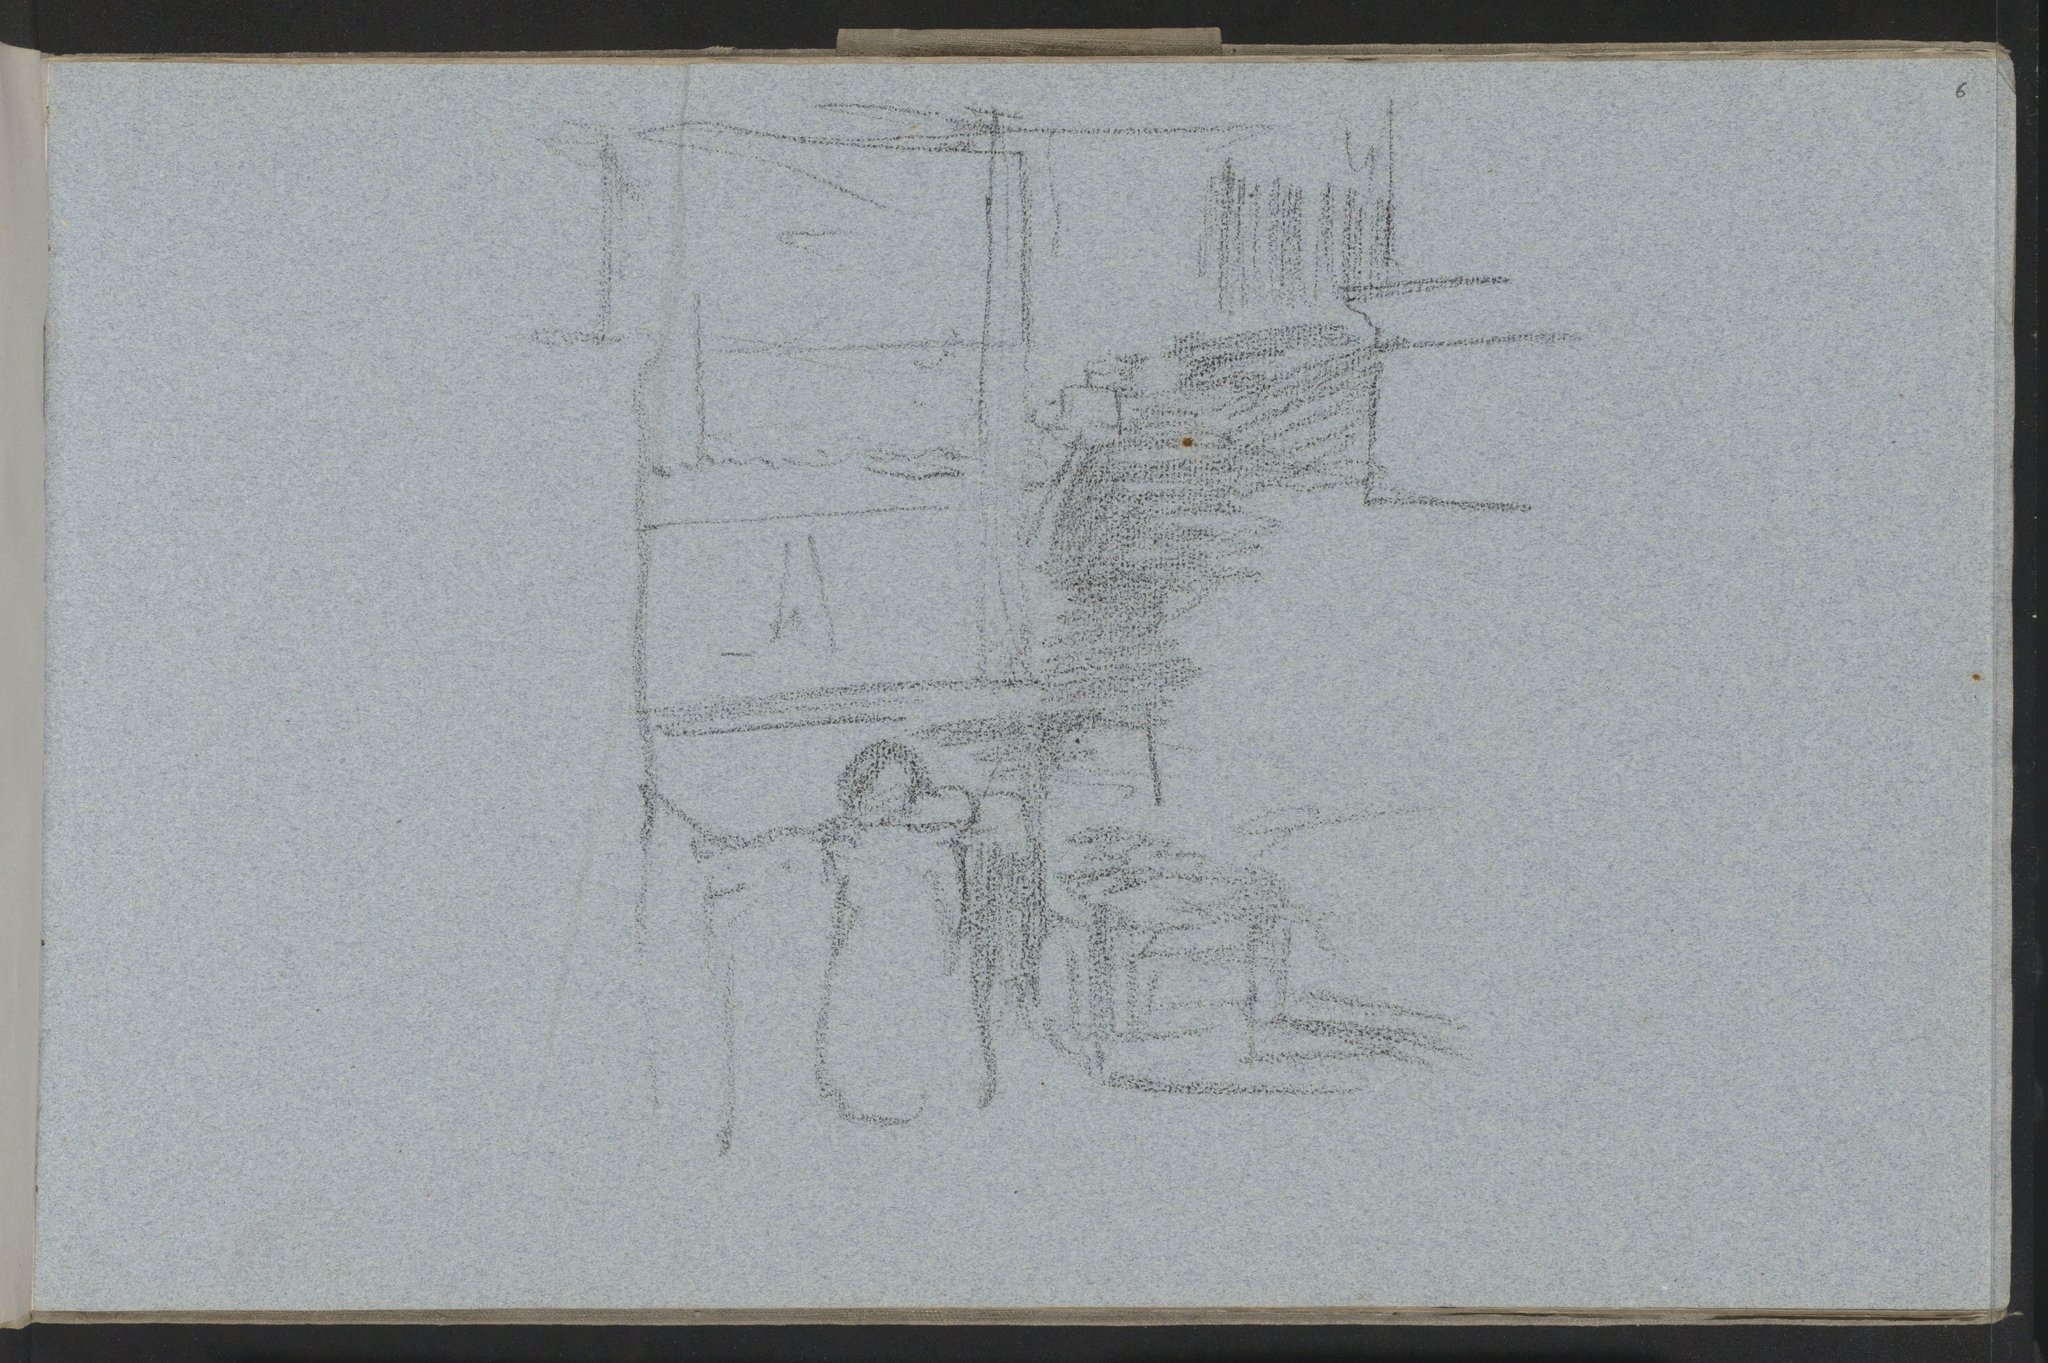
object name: sketchbook leaf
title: Interieur met een kind bij een raam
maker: albert neuhuys (1844-1914)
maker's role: draughtsman, painter, print maker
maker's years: 1844-1914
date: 1854-1914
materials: charcoal, paper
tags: toddler, window, interior of the house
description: Blad 6 recto uit een schetsboek met 51 bladen.